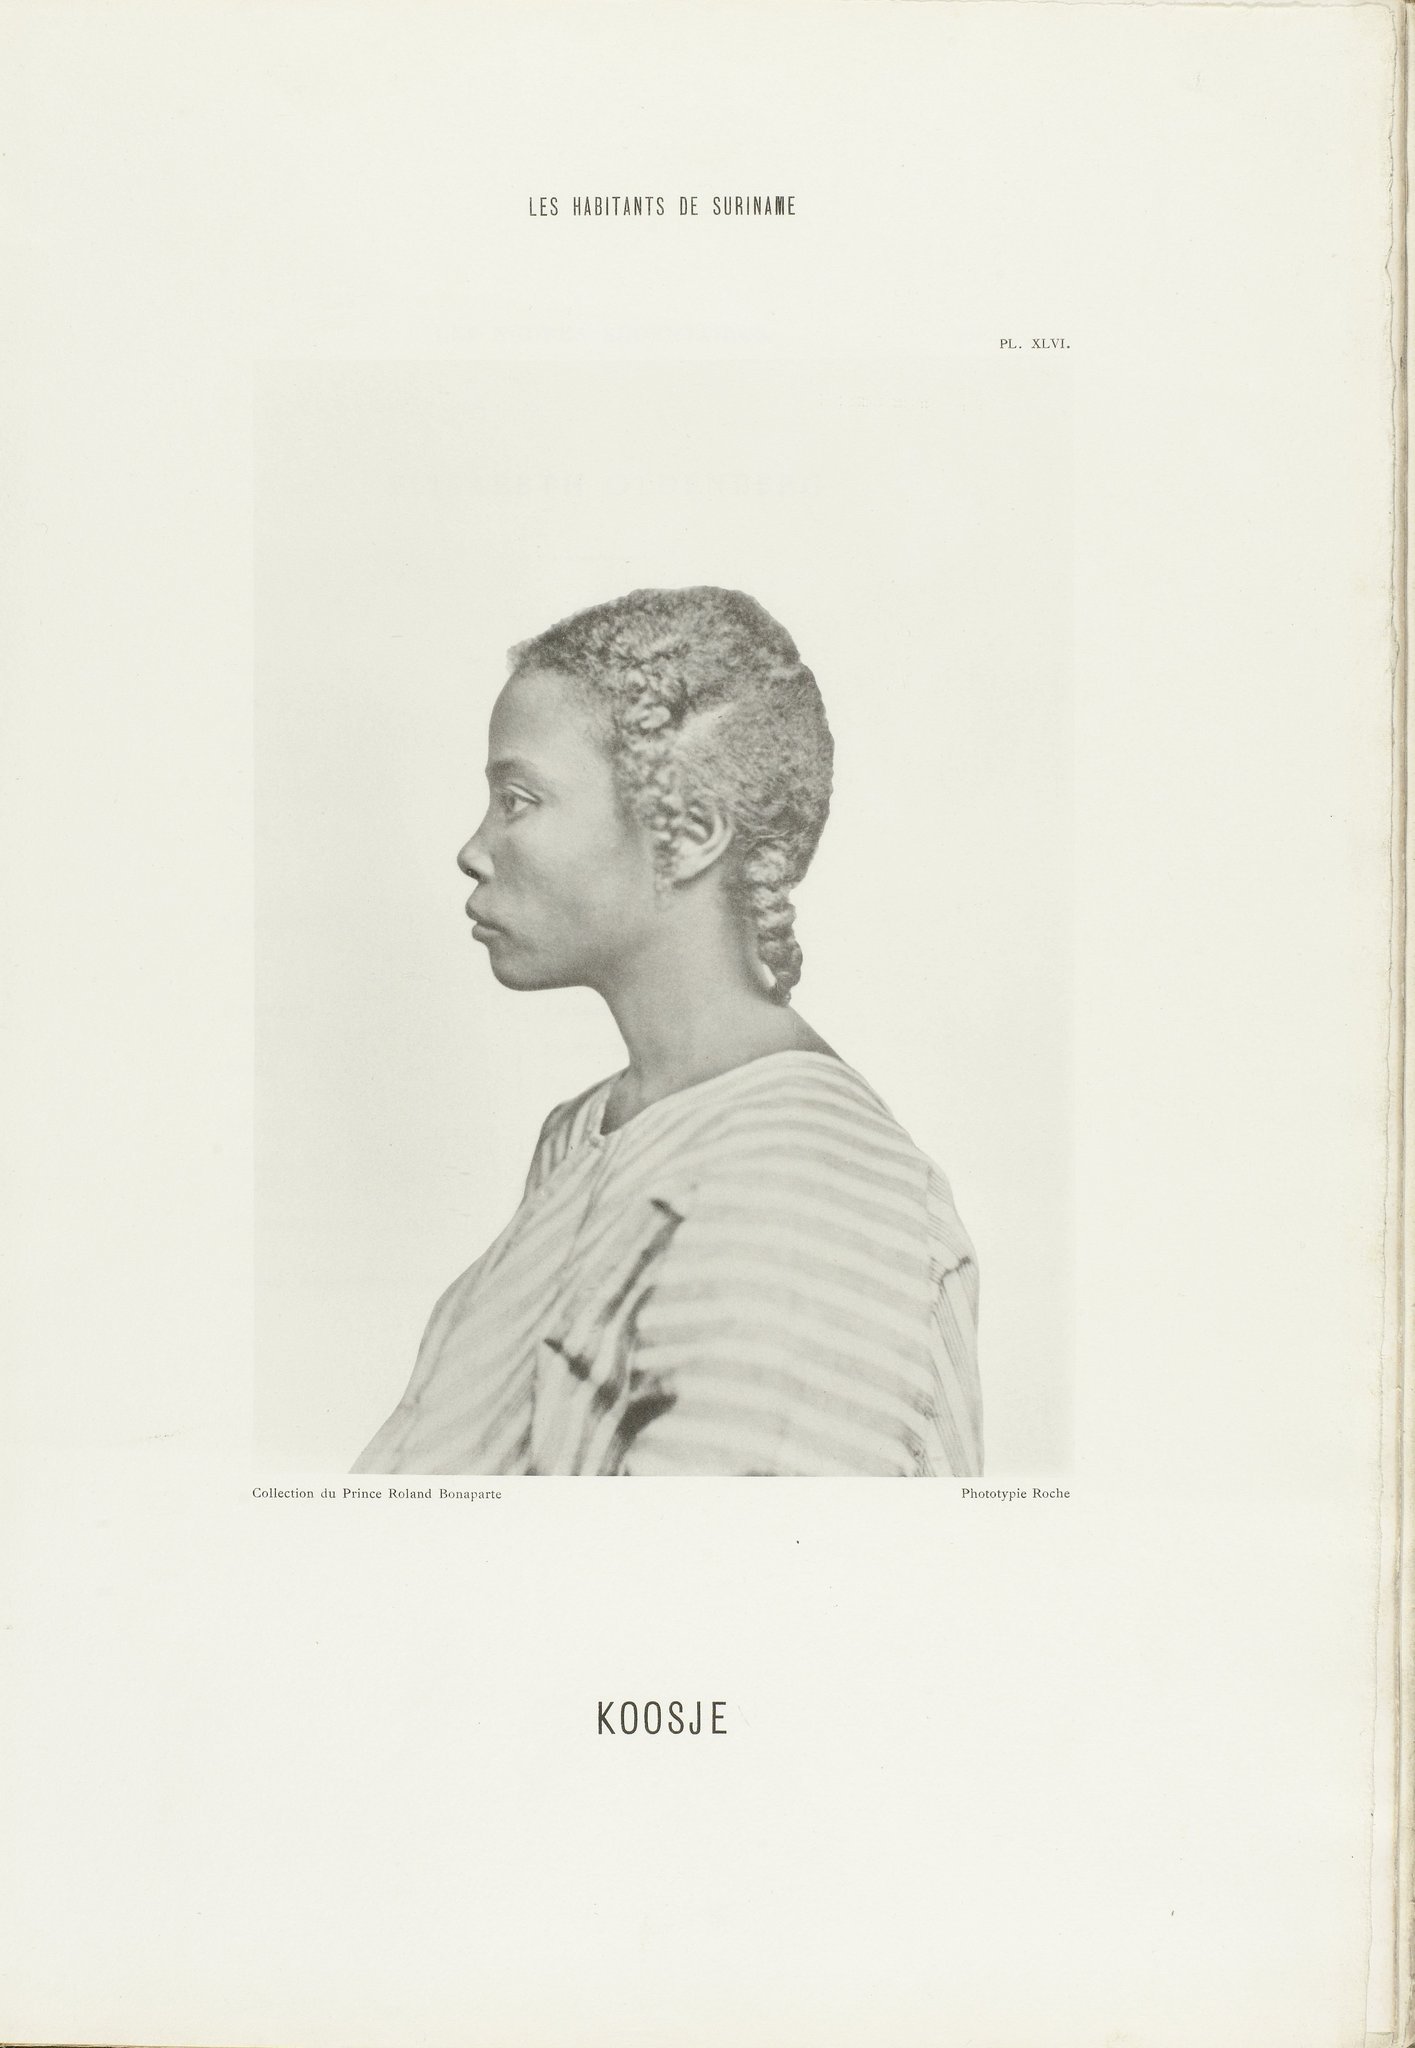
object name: page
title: Portret van Koosje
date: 1883-1884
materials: paper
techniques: photograph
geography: amsterdam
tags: adult woman, historical persons, amsterdam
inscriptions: inscription: ‘Collection du Prince Roland Bonaparte/ Phototypie Roche’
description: Portret van Koosje (Antoinette), een Surinaamse vrouw van Afrikaanse en Europese oorsprong, gefotografeerd op de Internationale Koloniale en Uitvoerhandel Tentoonstelling, Amsterdam 1883.